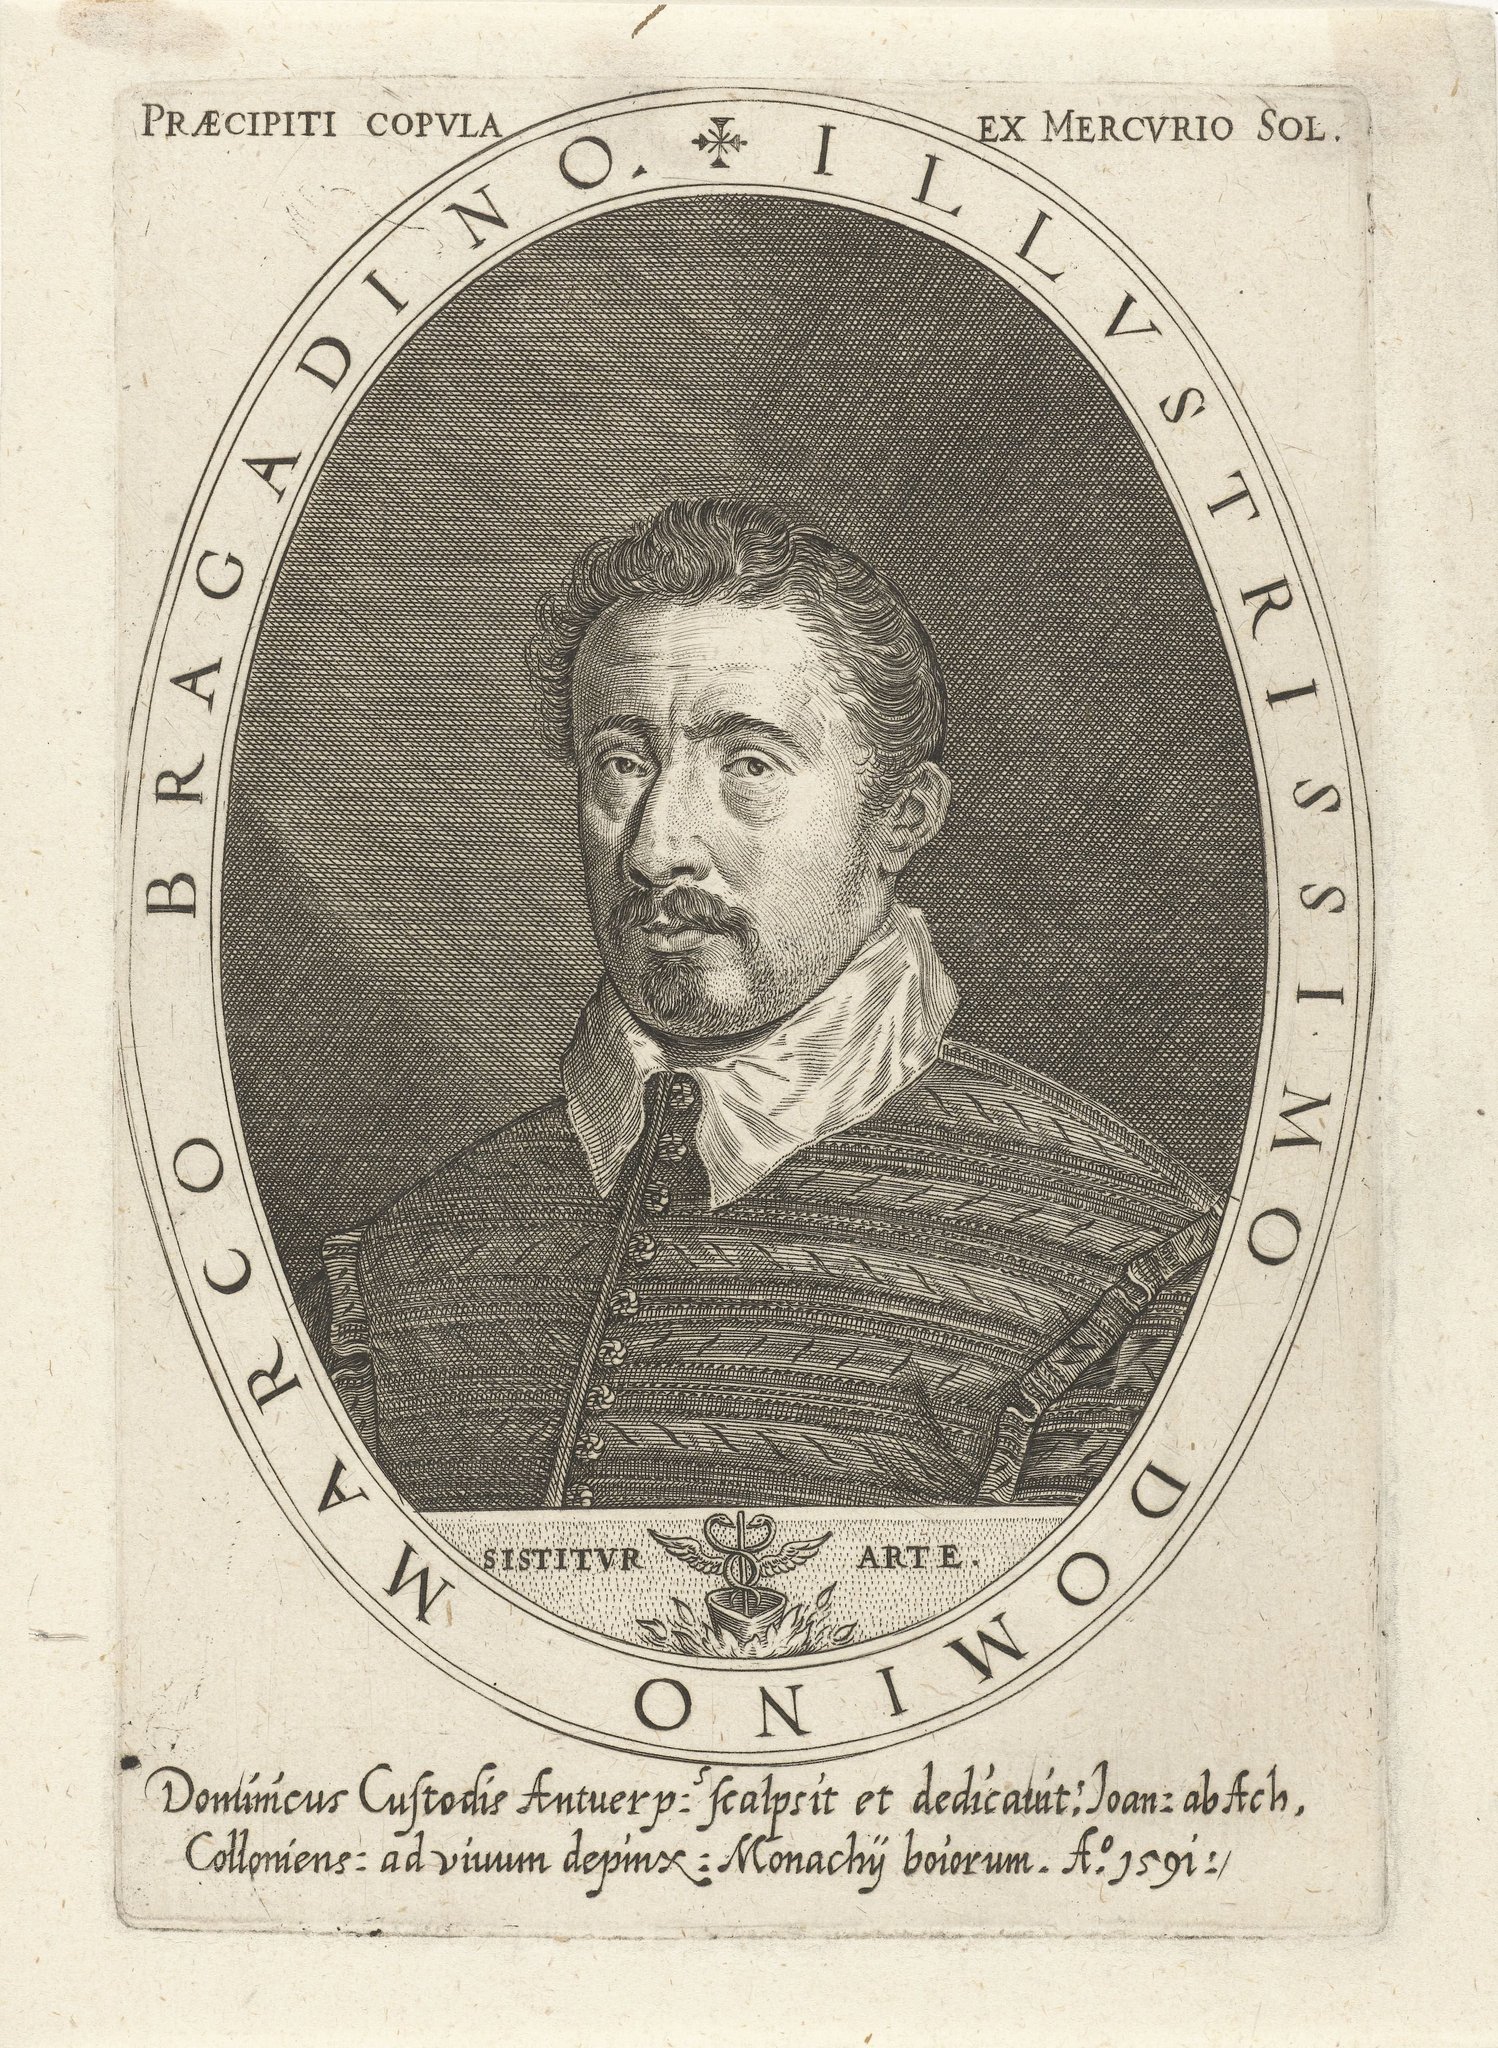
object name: print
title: Portret van Marco Bragadino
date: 1591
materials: paper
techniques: engraving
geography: bavaria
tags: marco bragadino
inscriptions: collector's mark: Lugt 2228